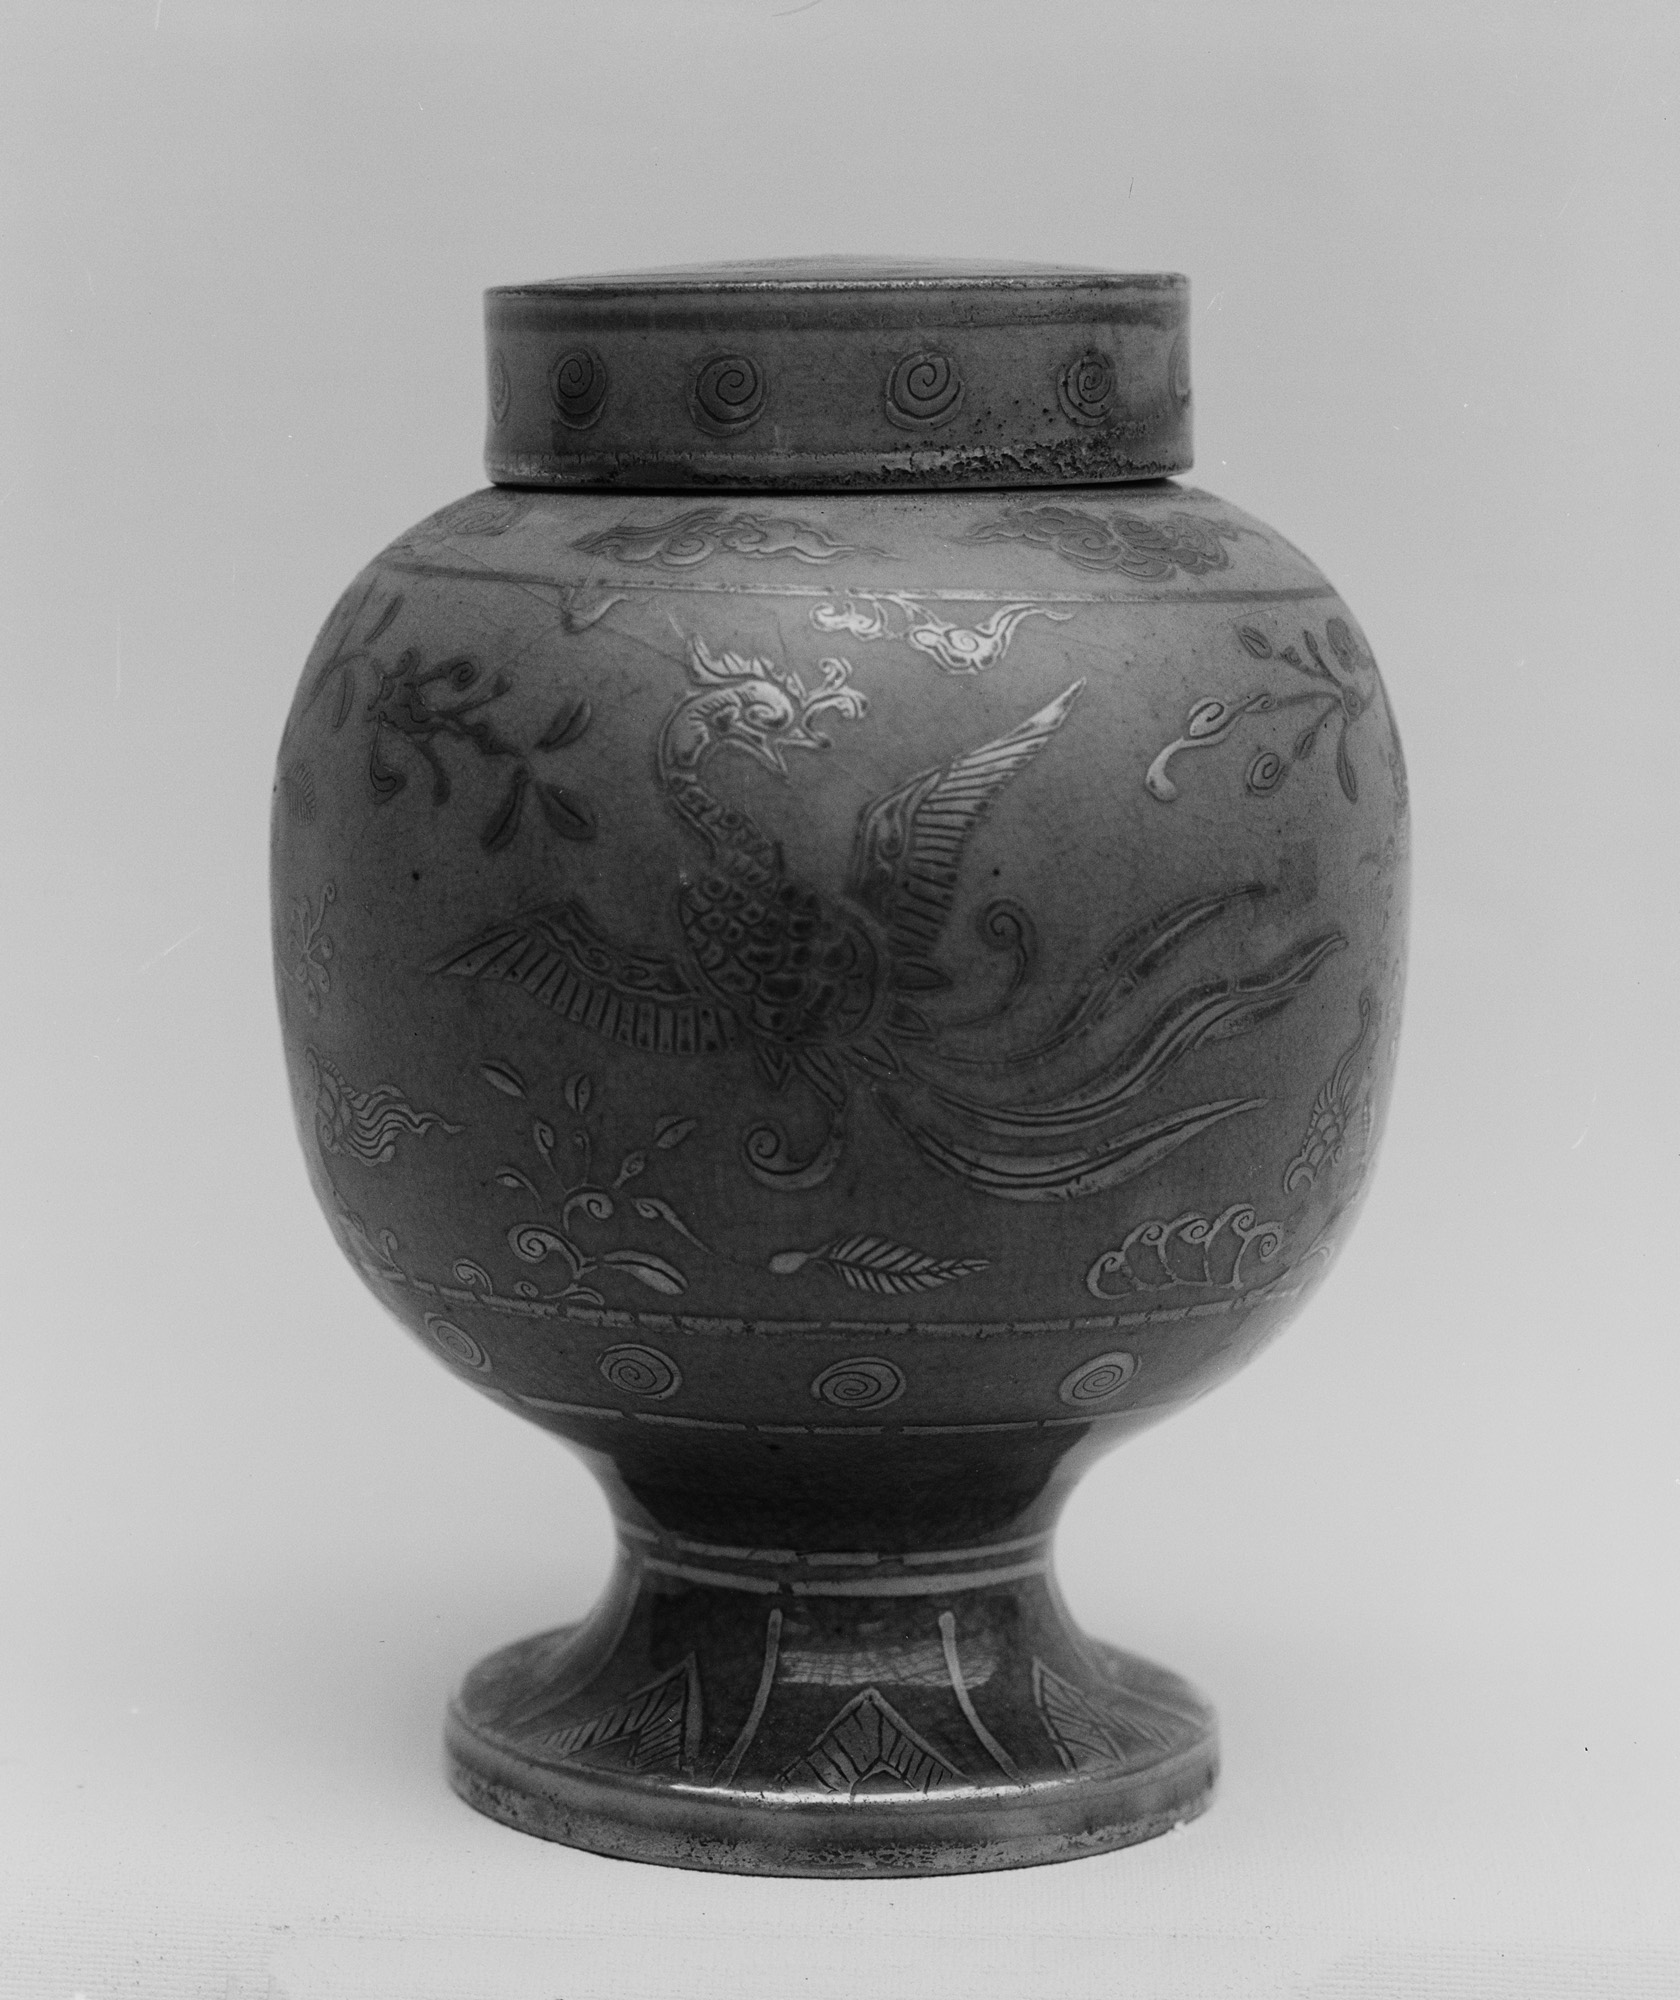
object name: jar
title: Jar for Sweets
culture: japanese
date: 1840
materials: gold, porcelain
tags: mythical creatures